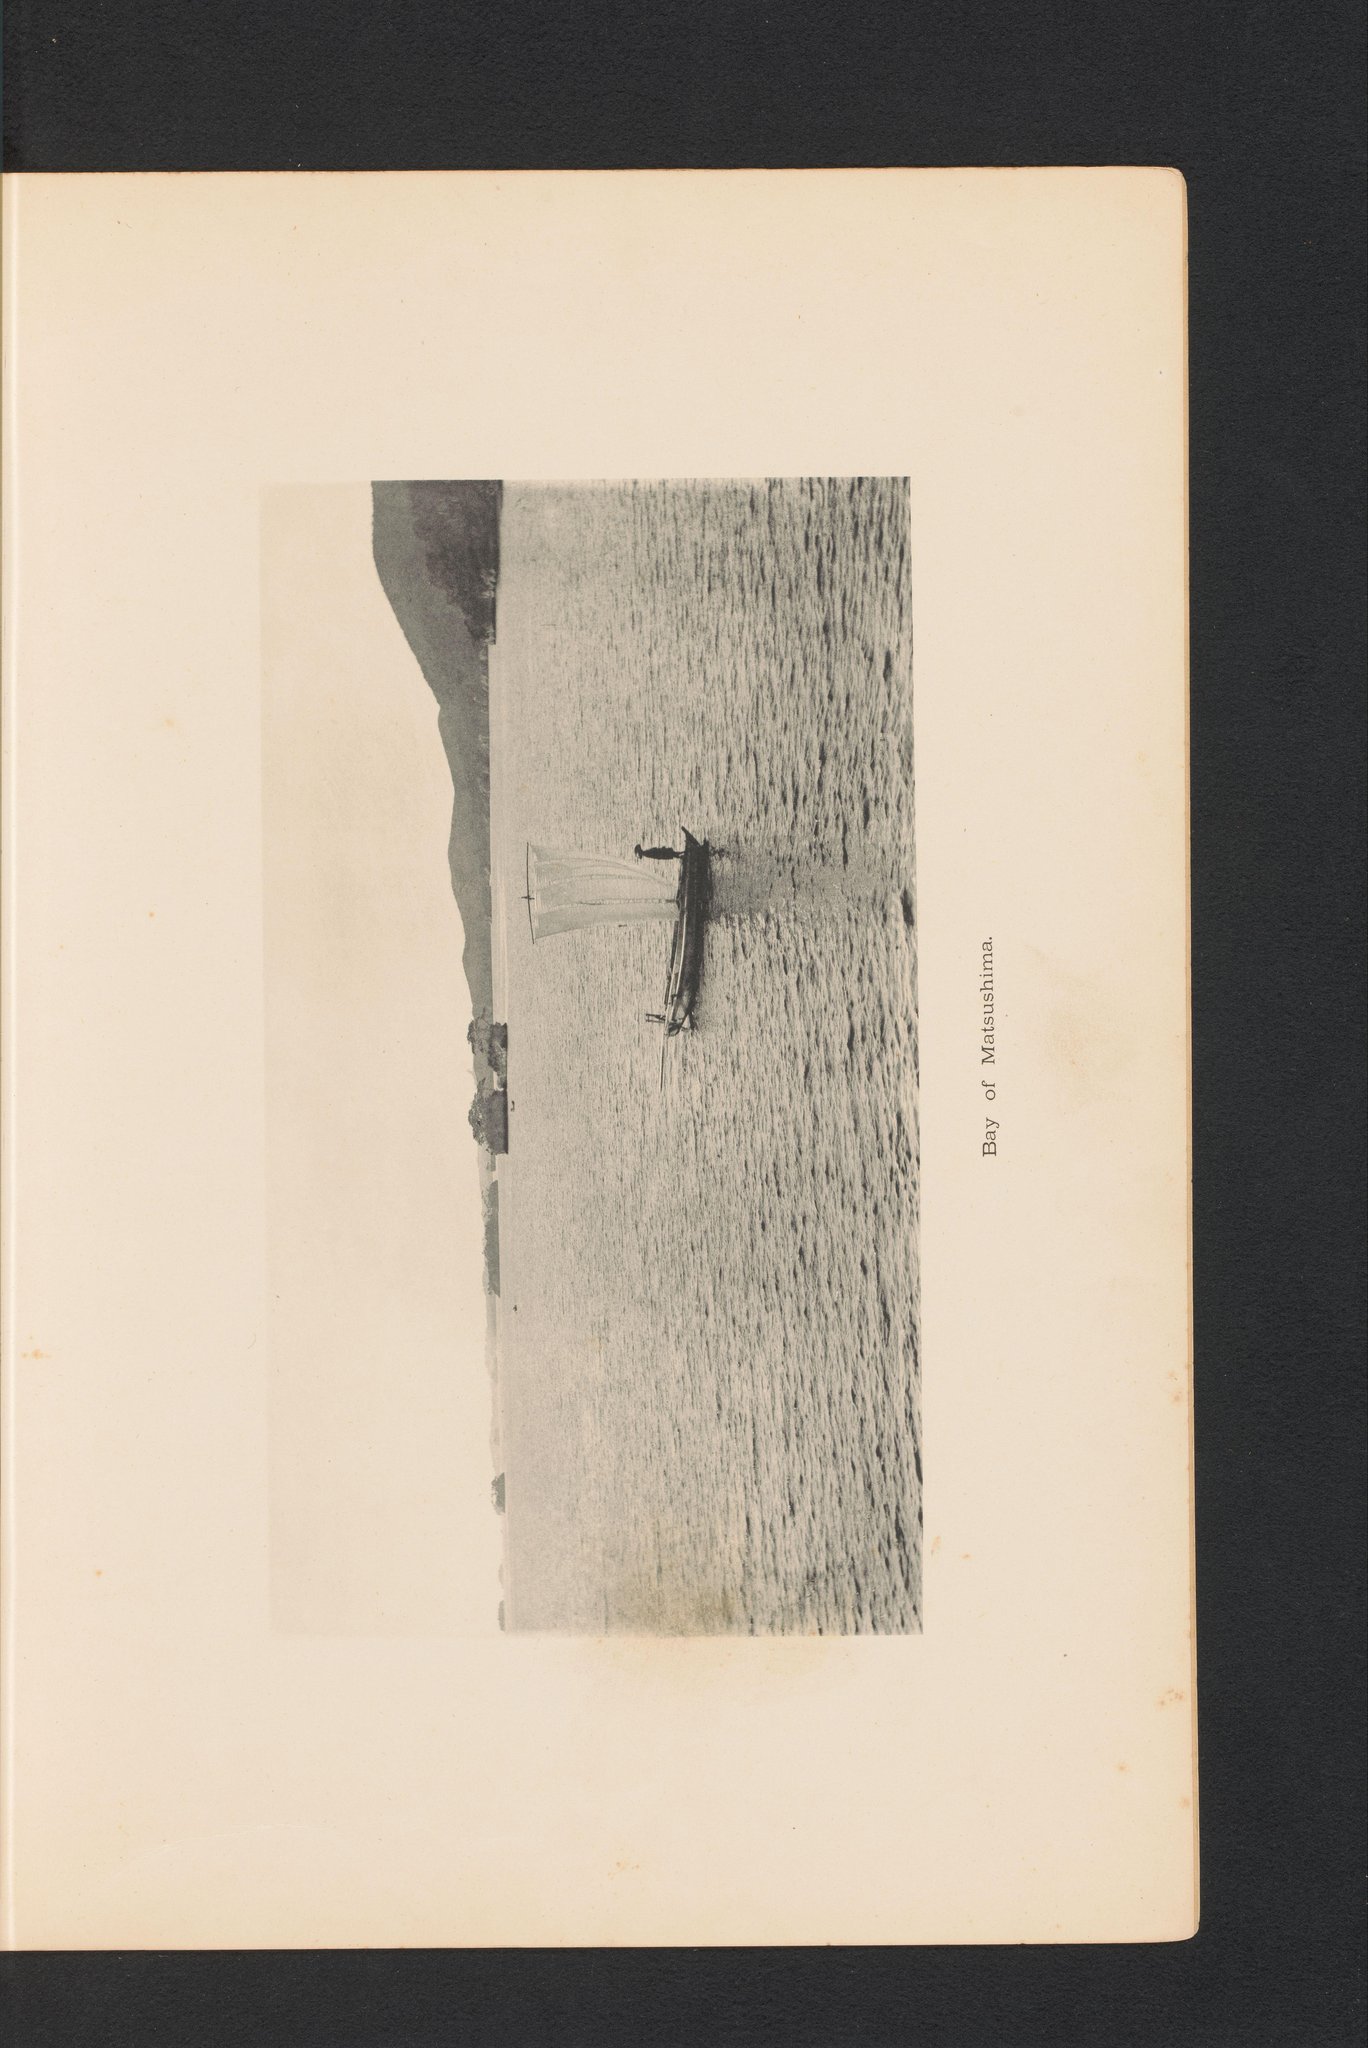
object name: page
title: Gezicht op de baai van Matsushima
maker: kazumasa ogawa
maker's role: auteur, fotograaf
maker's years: 1860-1929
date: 1890-1895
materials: paper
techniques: photograph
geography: matsushima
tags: gulf, bay (+ landscape with figures, staffage), sailing-ship, sailing-boat